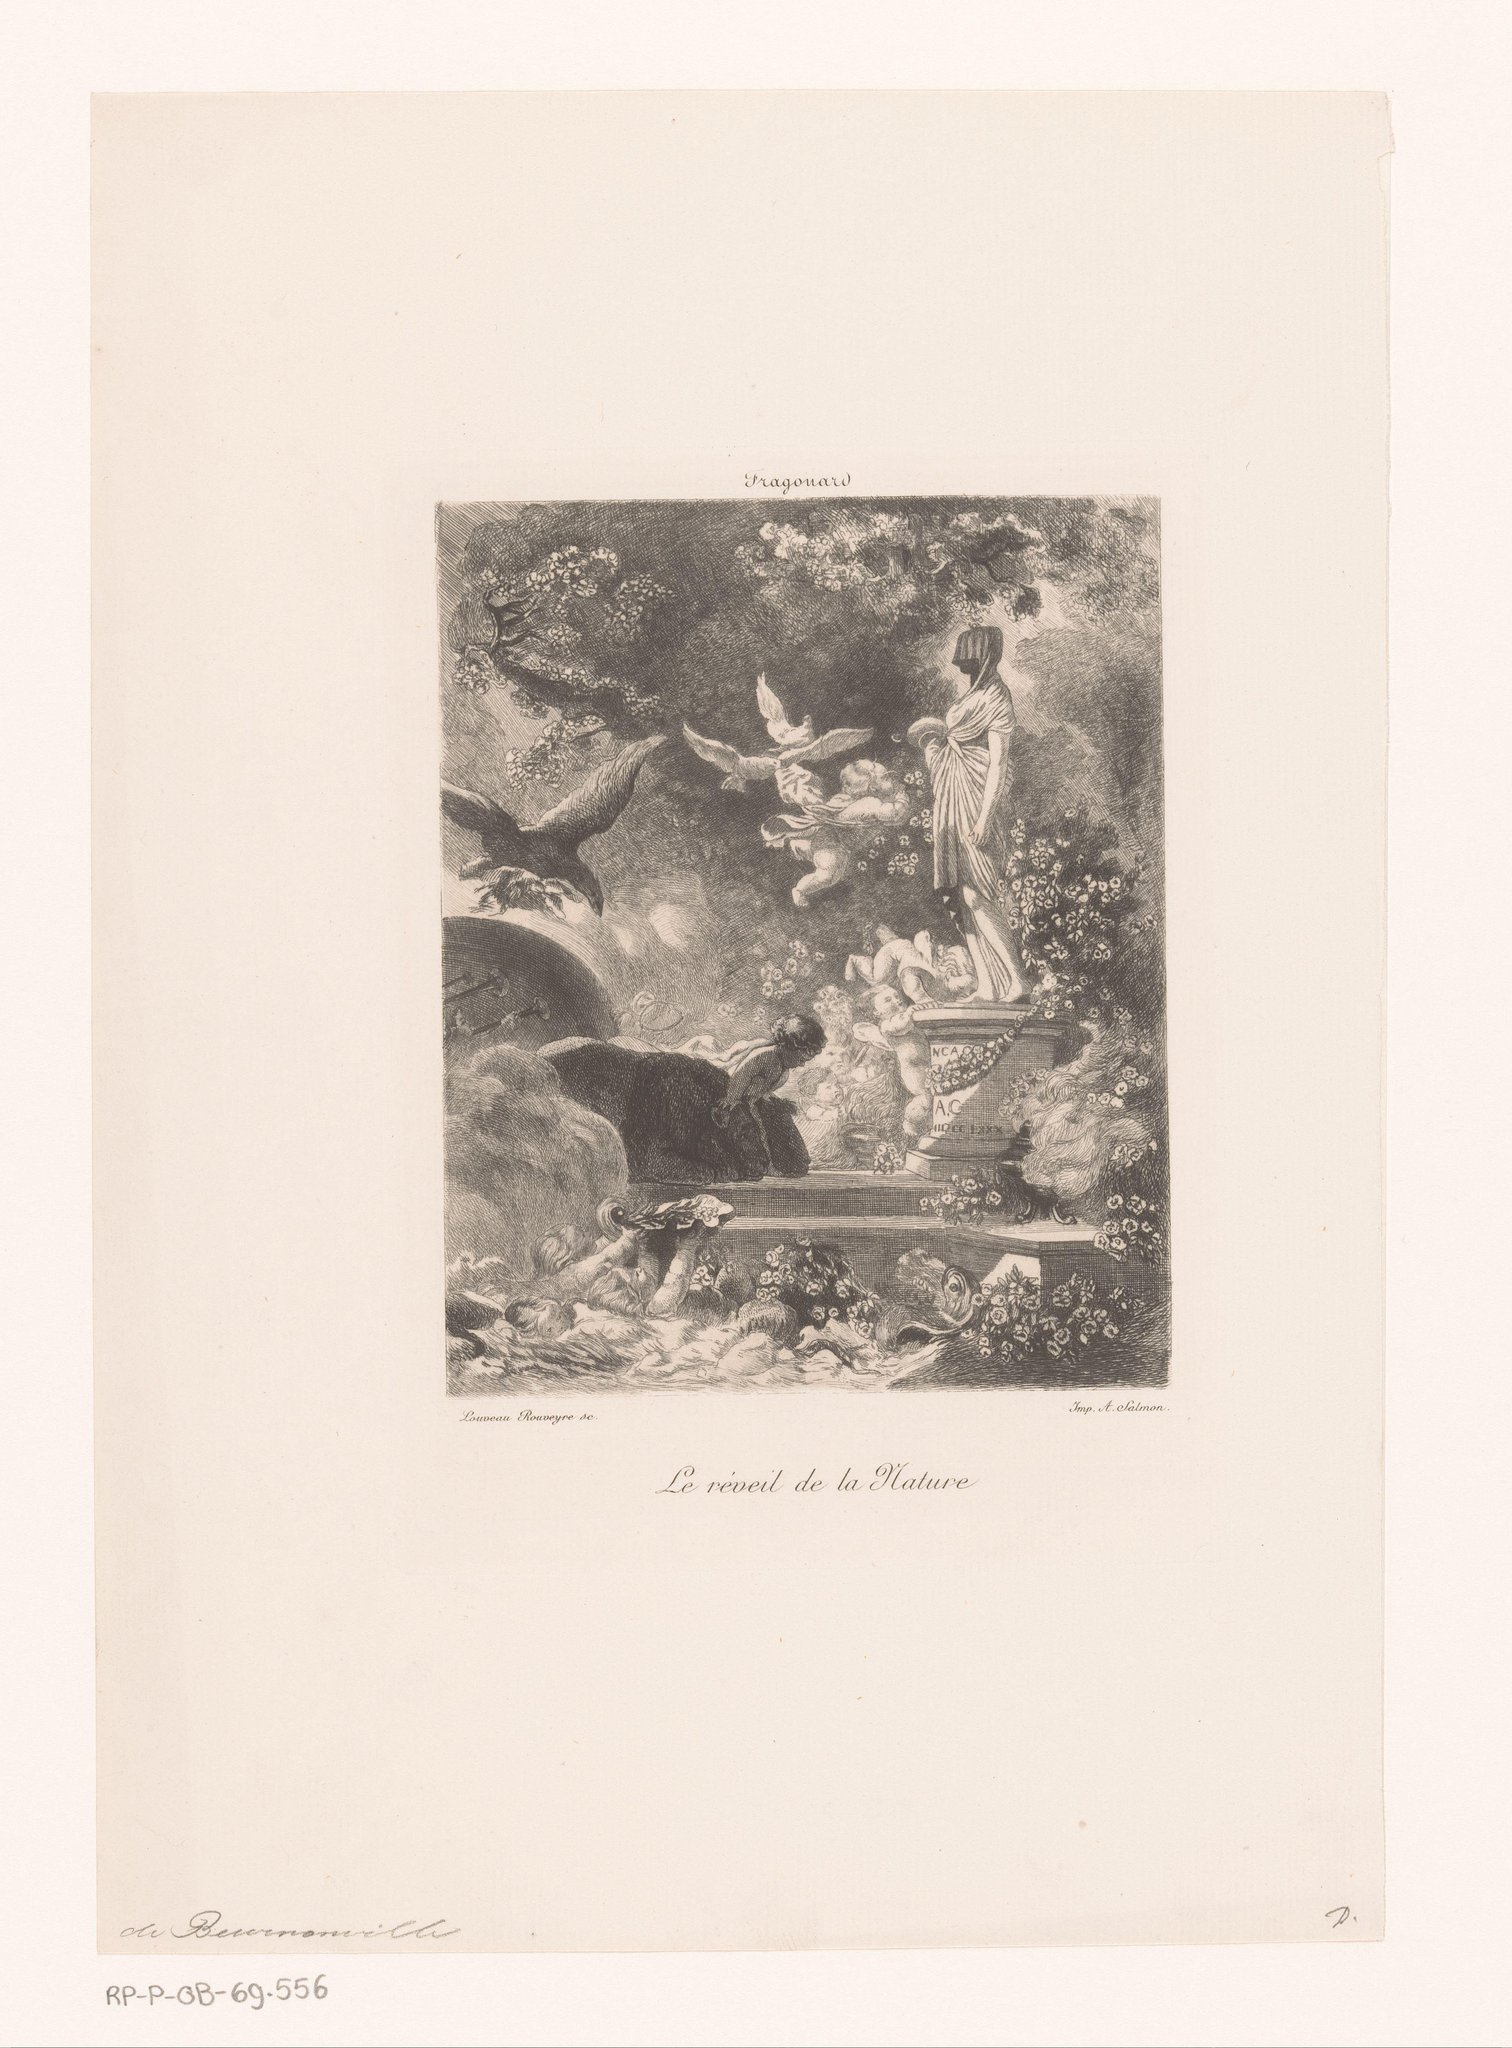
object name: print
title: Parklandschap met putti bij een gesluierd standbeeld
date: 1878-1904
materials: paper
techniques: etching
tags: park, cupids: 'amores', 'amoretti', 'putti', nature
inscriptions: collector's mark: Lugt 2228